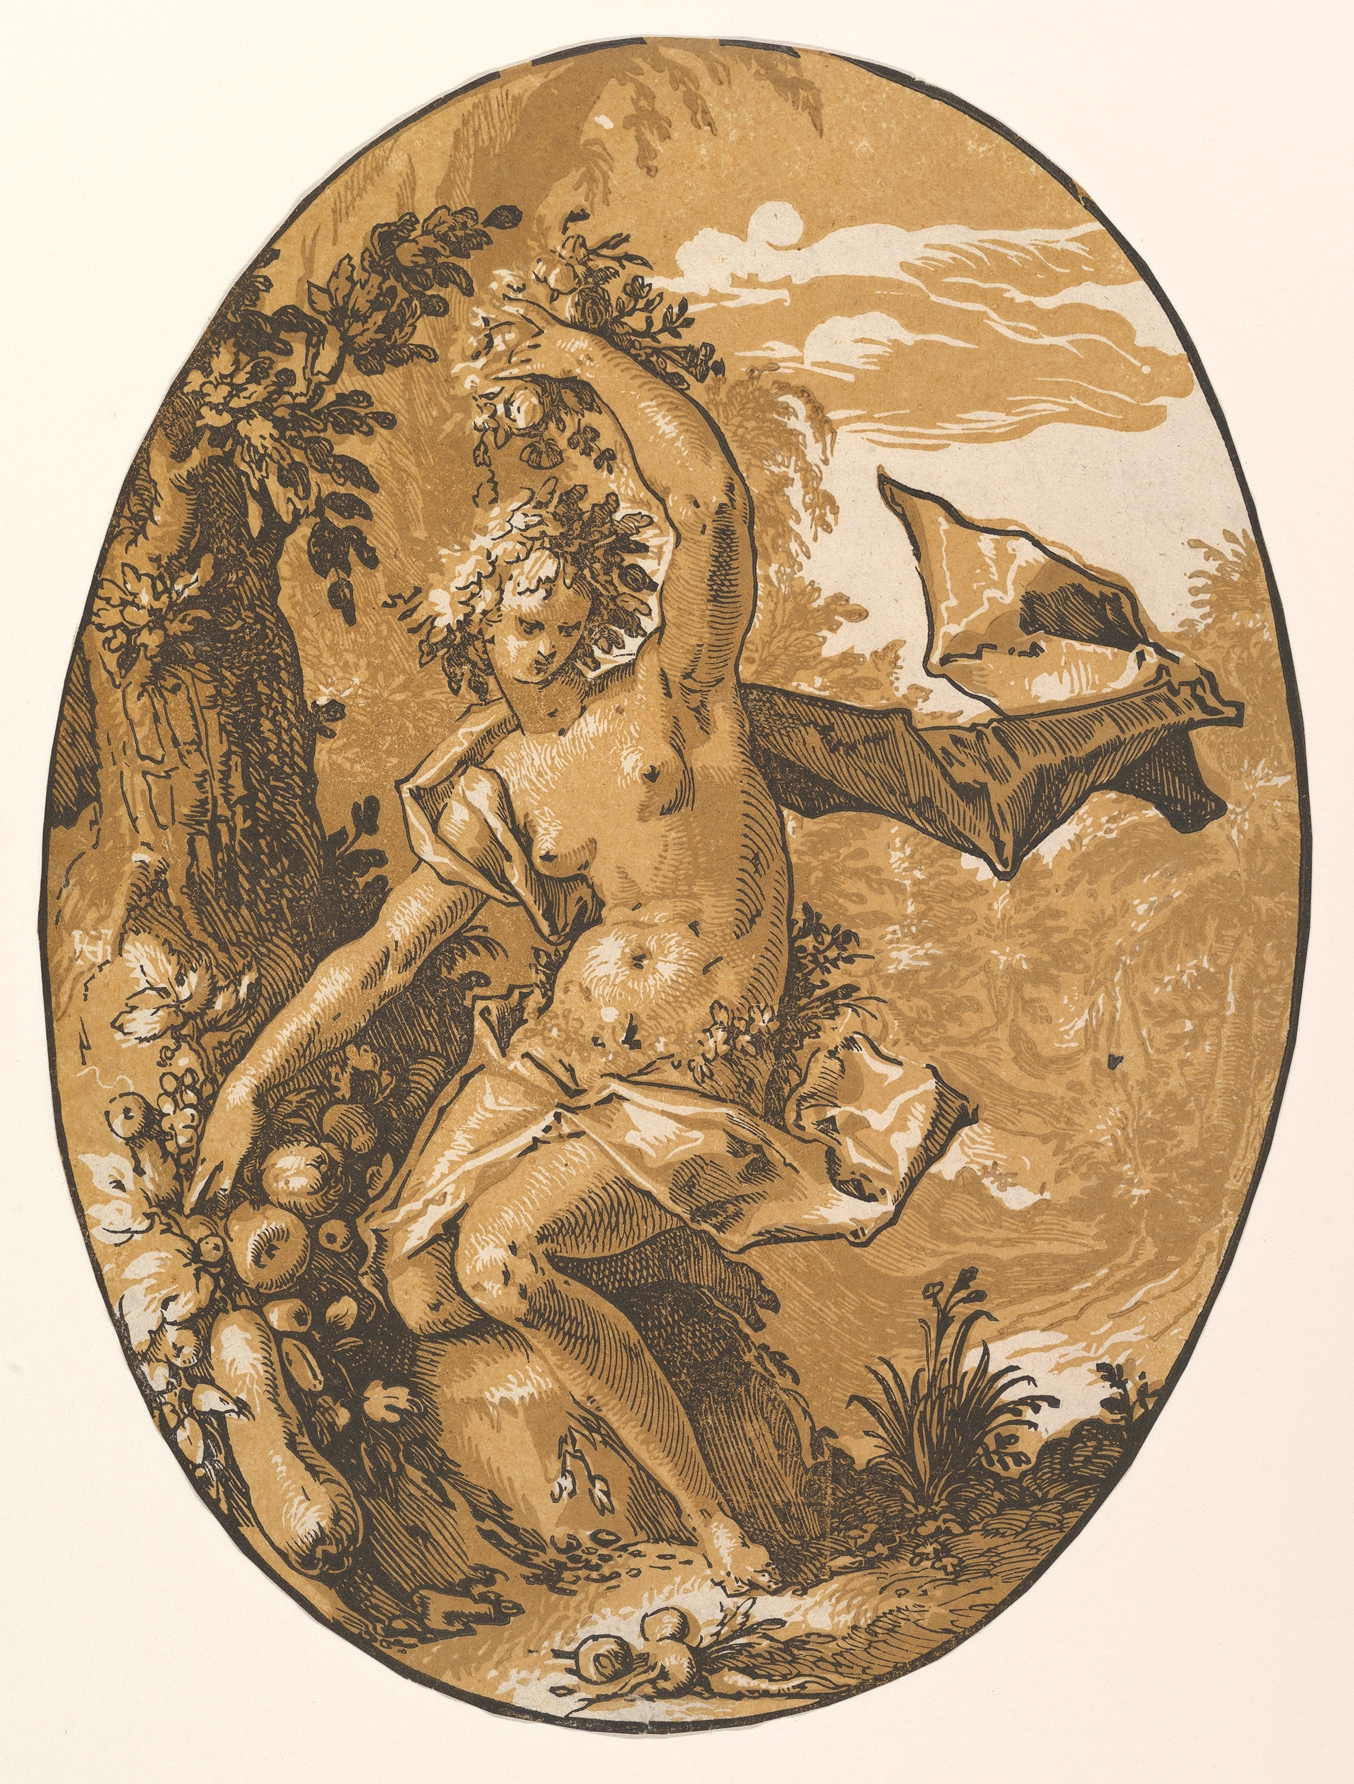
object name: print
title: Proserpina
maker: hendrick goltzius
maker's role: artist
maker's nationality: netherlandish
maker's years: 1558-1617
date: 1594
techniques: woodcut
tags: trees,goddess